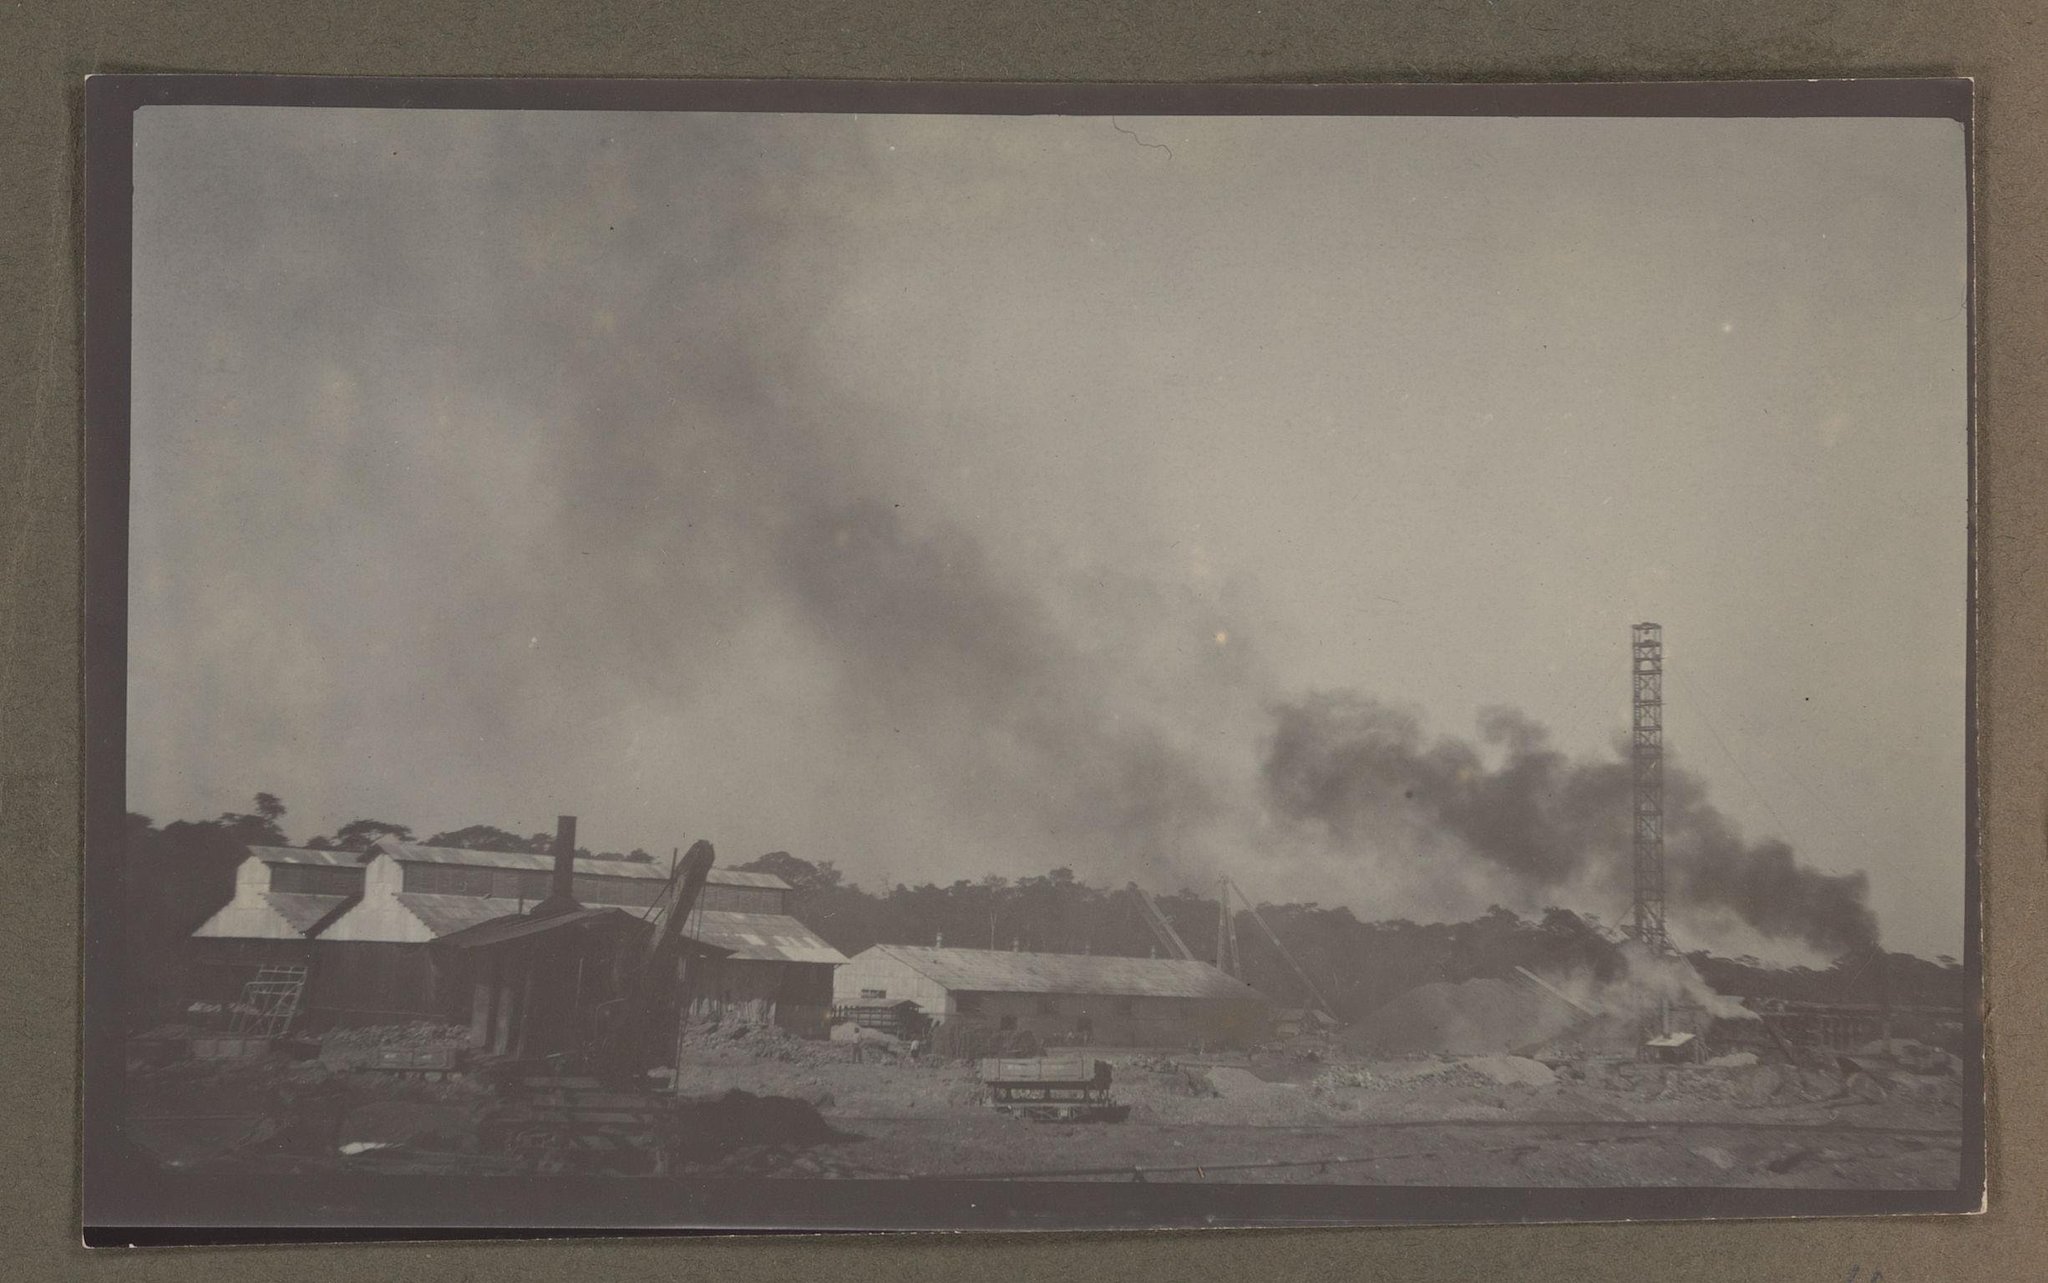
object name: photograph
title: Mijn en fabriek in Moengo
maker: Anonymous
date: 1925-1927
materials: photographic support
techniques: photography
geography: suriname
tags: jetten, familie, moengo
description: Terrein van de mijn en fabriek in Moengo. Foto op een bladzijde van een los albumblad. Onderdeel van het ensemble met foto's van de familie van ingenieur Jetten in de mijnbouwstad Moengo in Suriname.